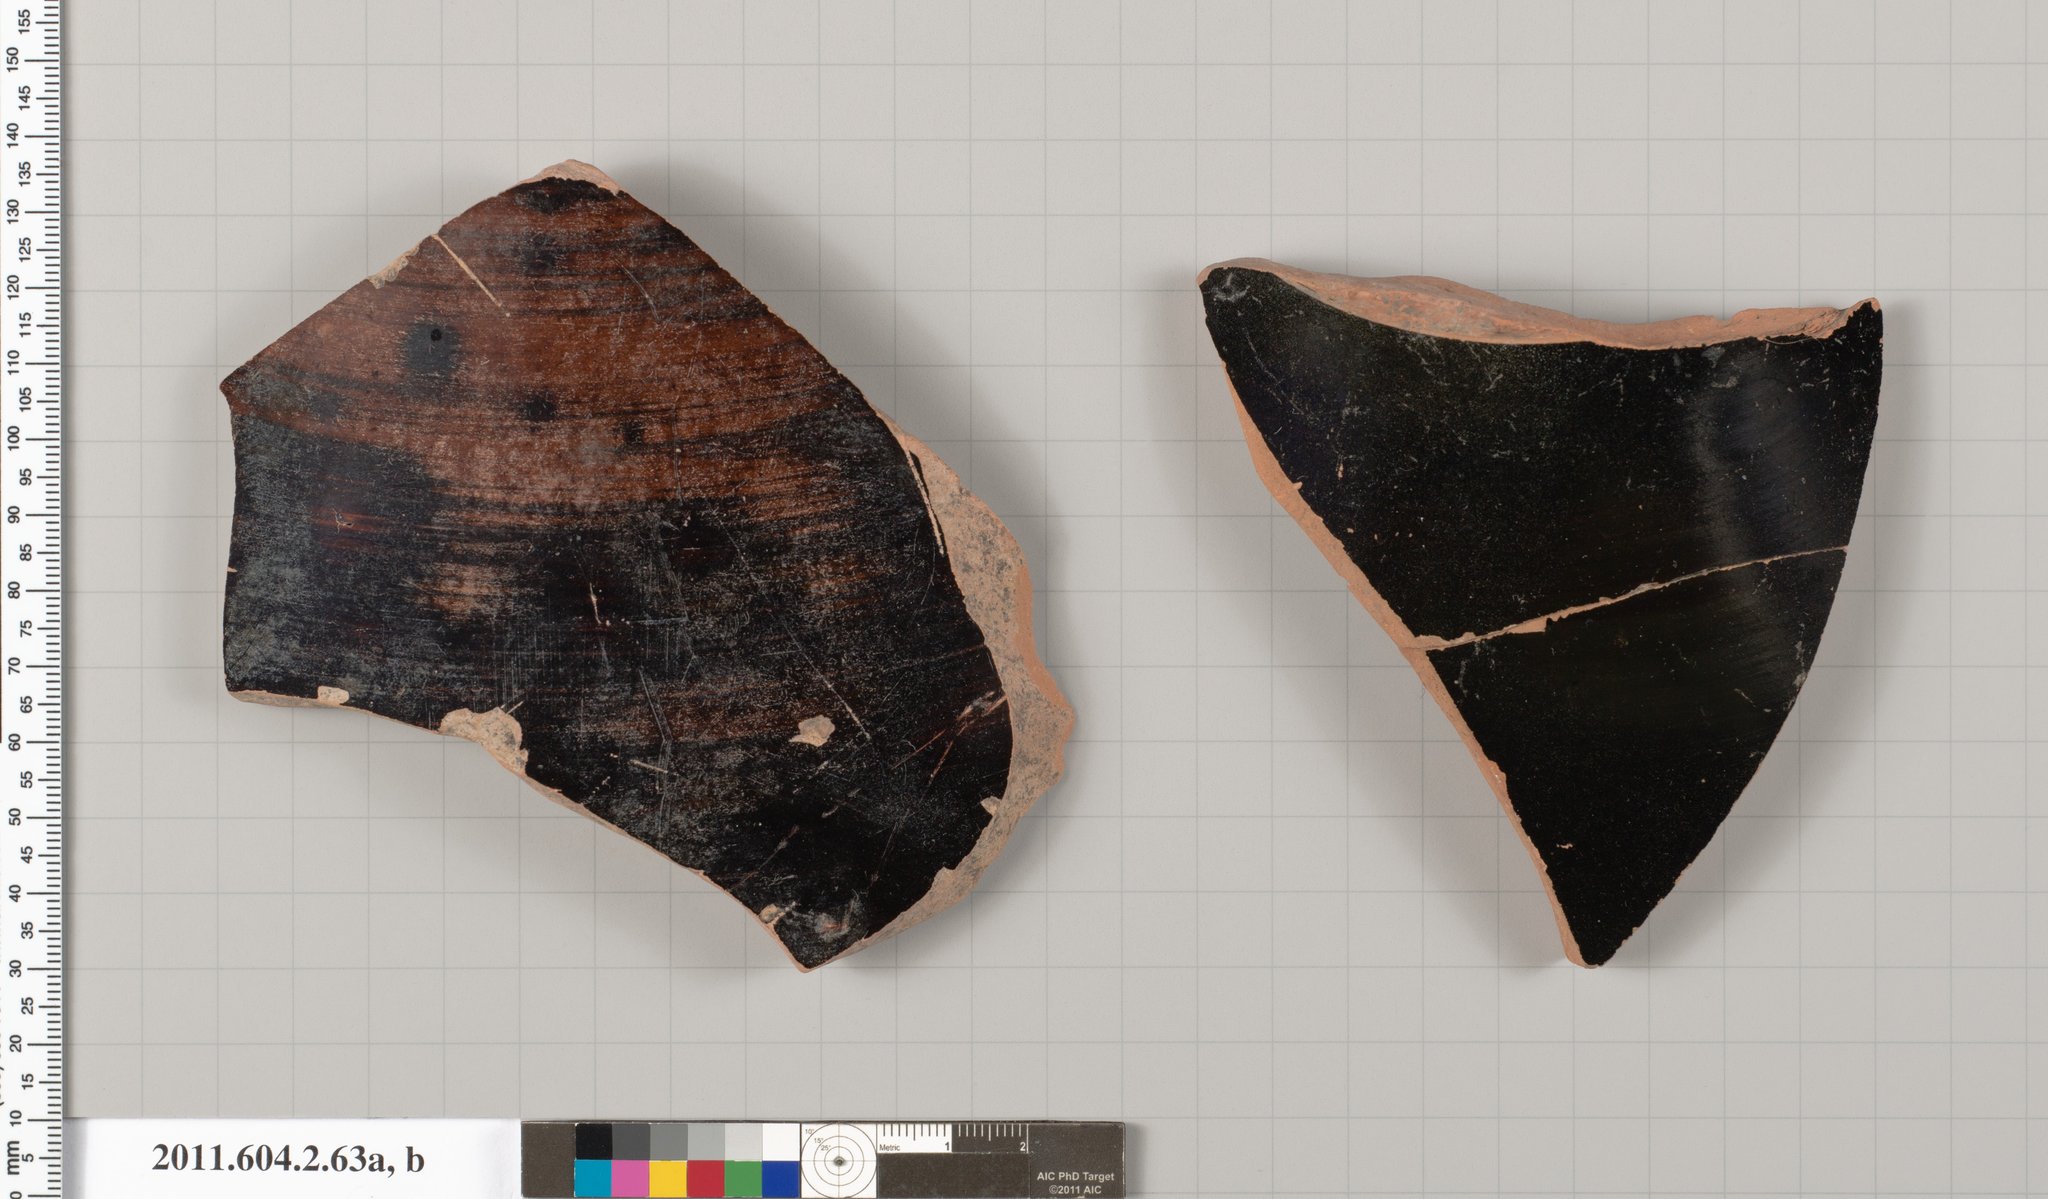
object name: pot fragment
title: Terracotta fragments of a pot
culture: greek, attic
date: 534-468 BCE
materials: terracotta